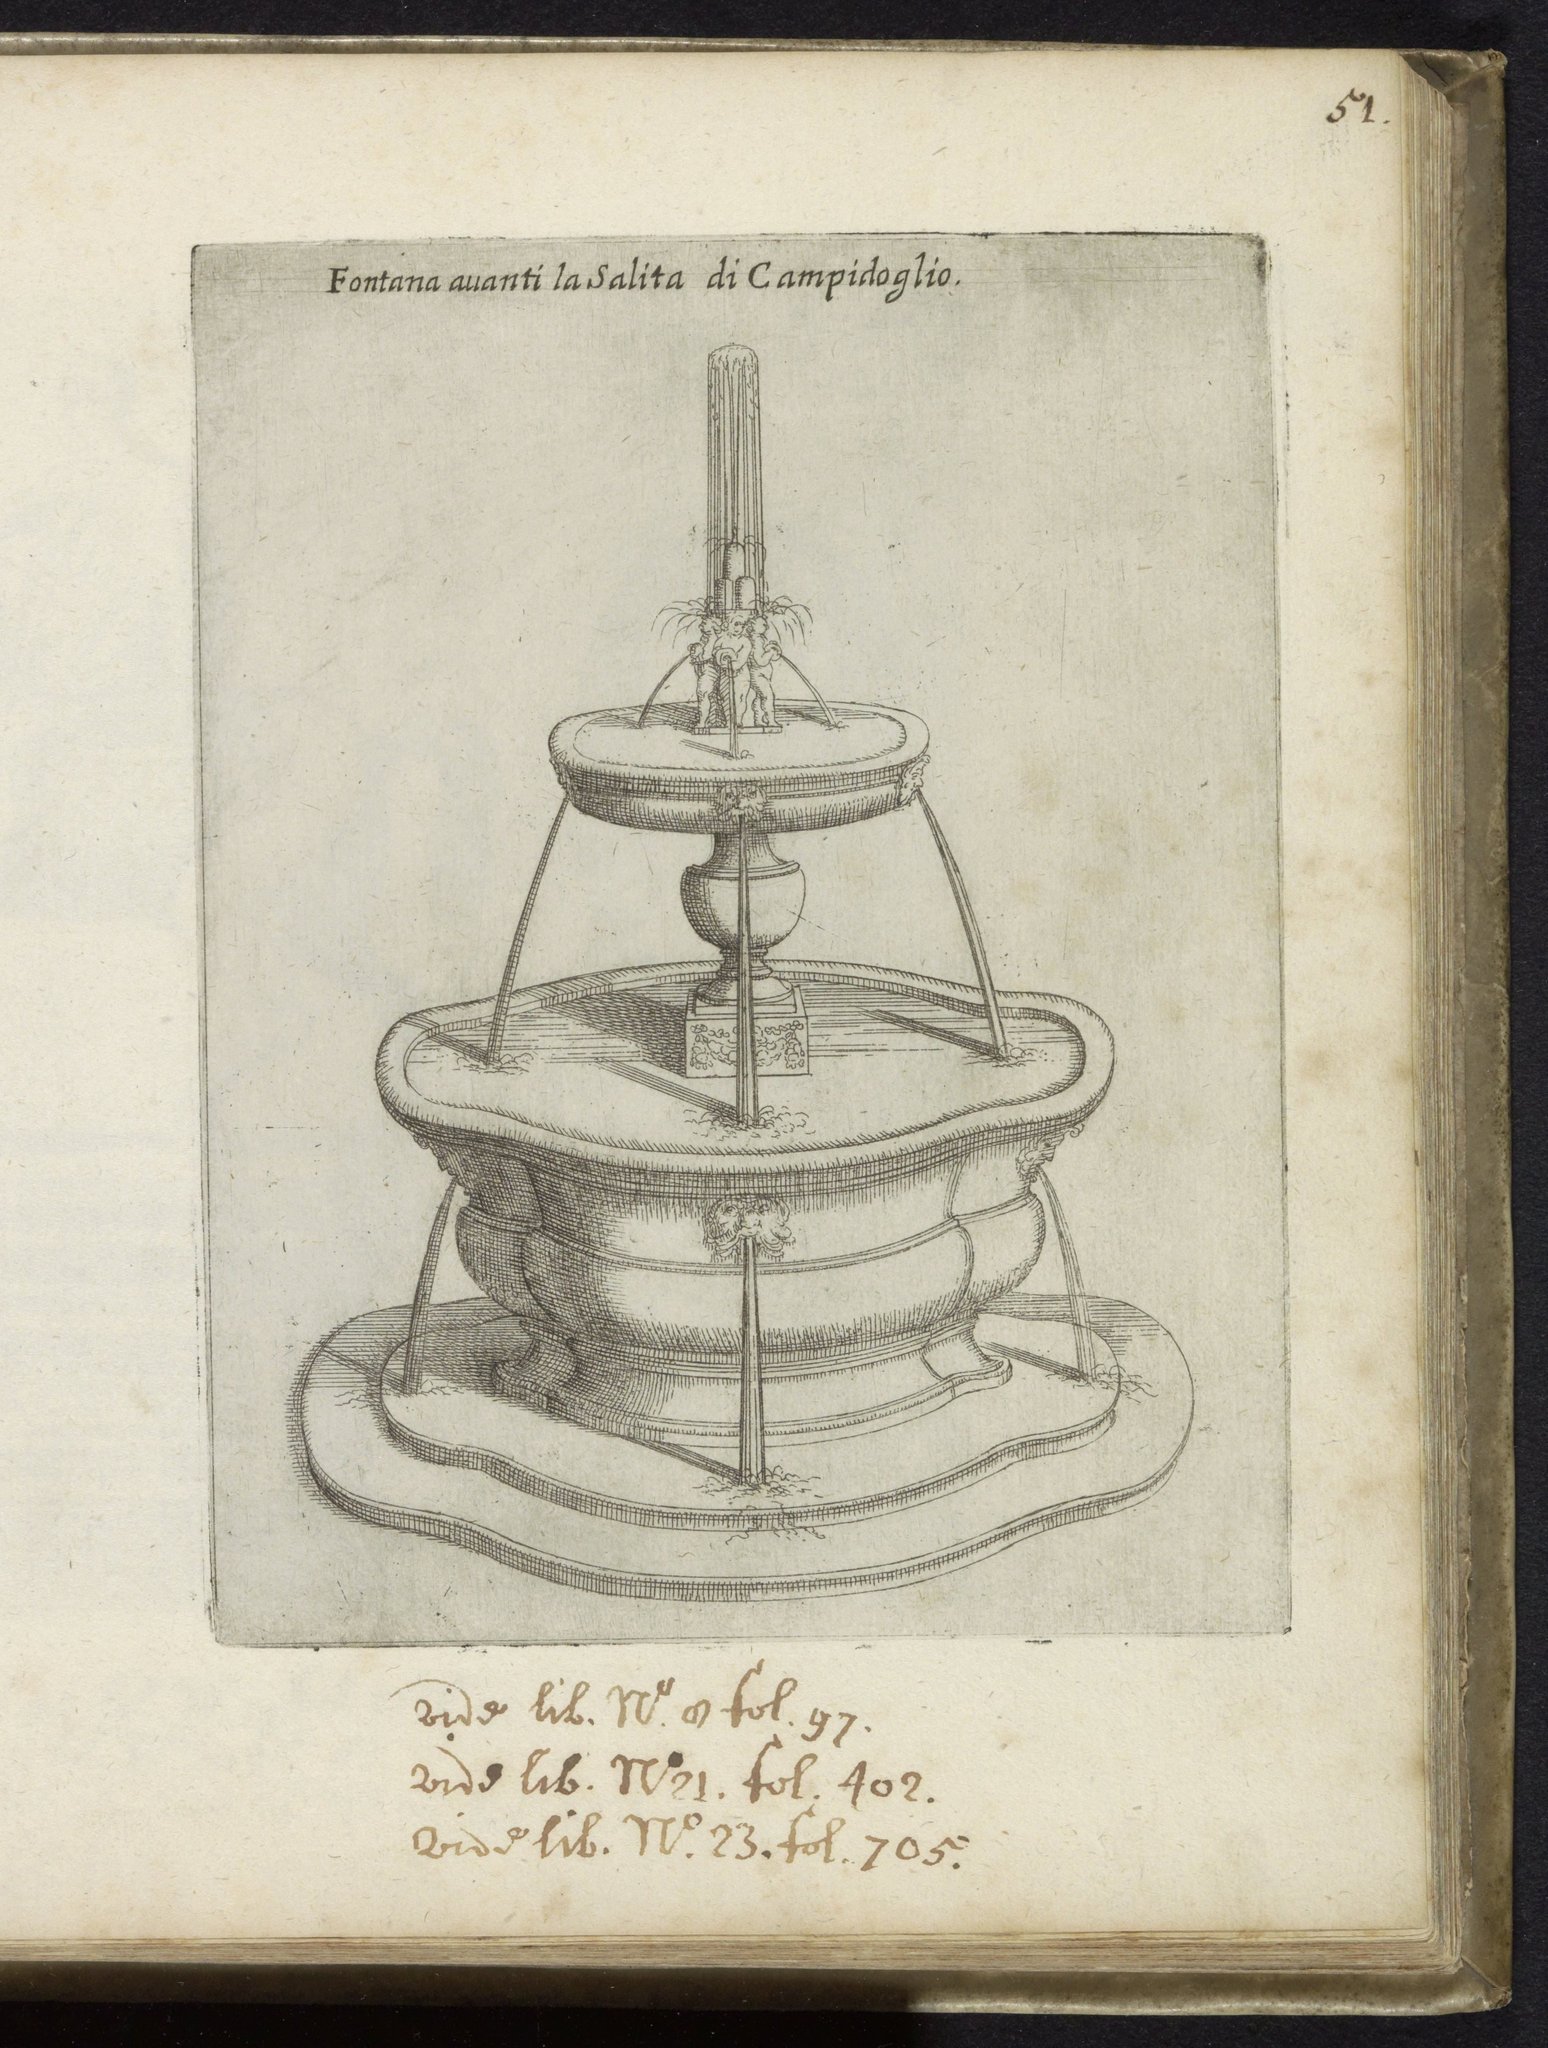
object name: album leaf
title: Fontein voor de trap naar het Capitool te Rome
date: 1637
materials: paper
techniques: etching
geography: italy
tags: ornamental fountain, rome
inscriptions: inscription: ‘Ende lib. No. 8. fol. 97./ Ende lib. No. 21. fol. 402./ Ende lib. No. 23. fol. 705.’, number: ‘51’, inscription: ‘Ende lib. No. 8 fol. 15./ Ende lib. No. 2. [...]/ Ende lib. No. 21. fol. 287 et 288.’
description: Deze prent maakt deel uit van een reeks van ten minste 20 prenten (+ titelprent) van fonteinen in Rome.